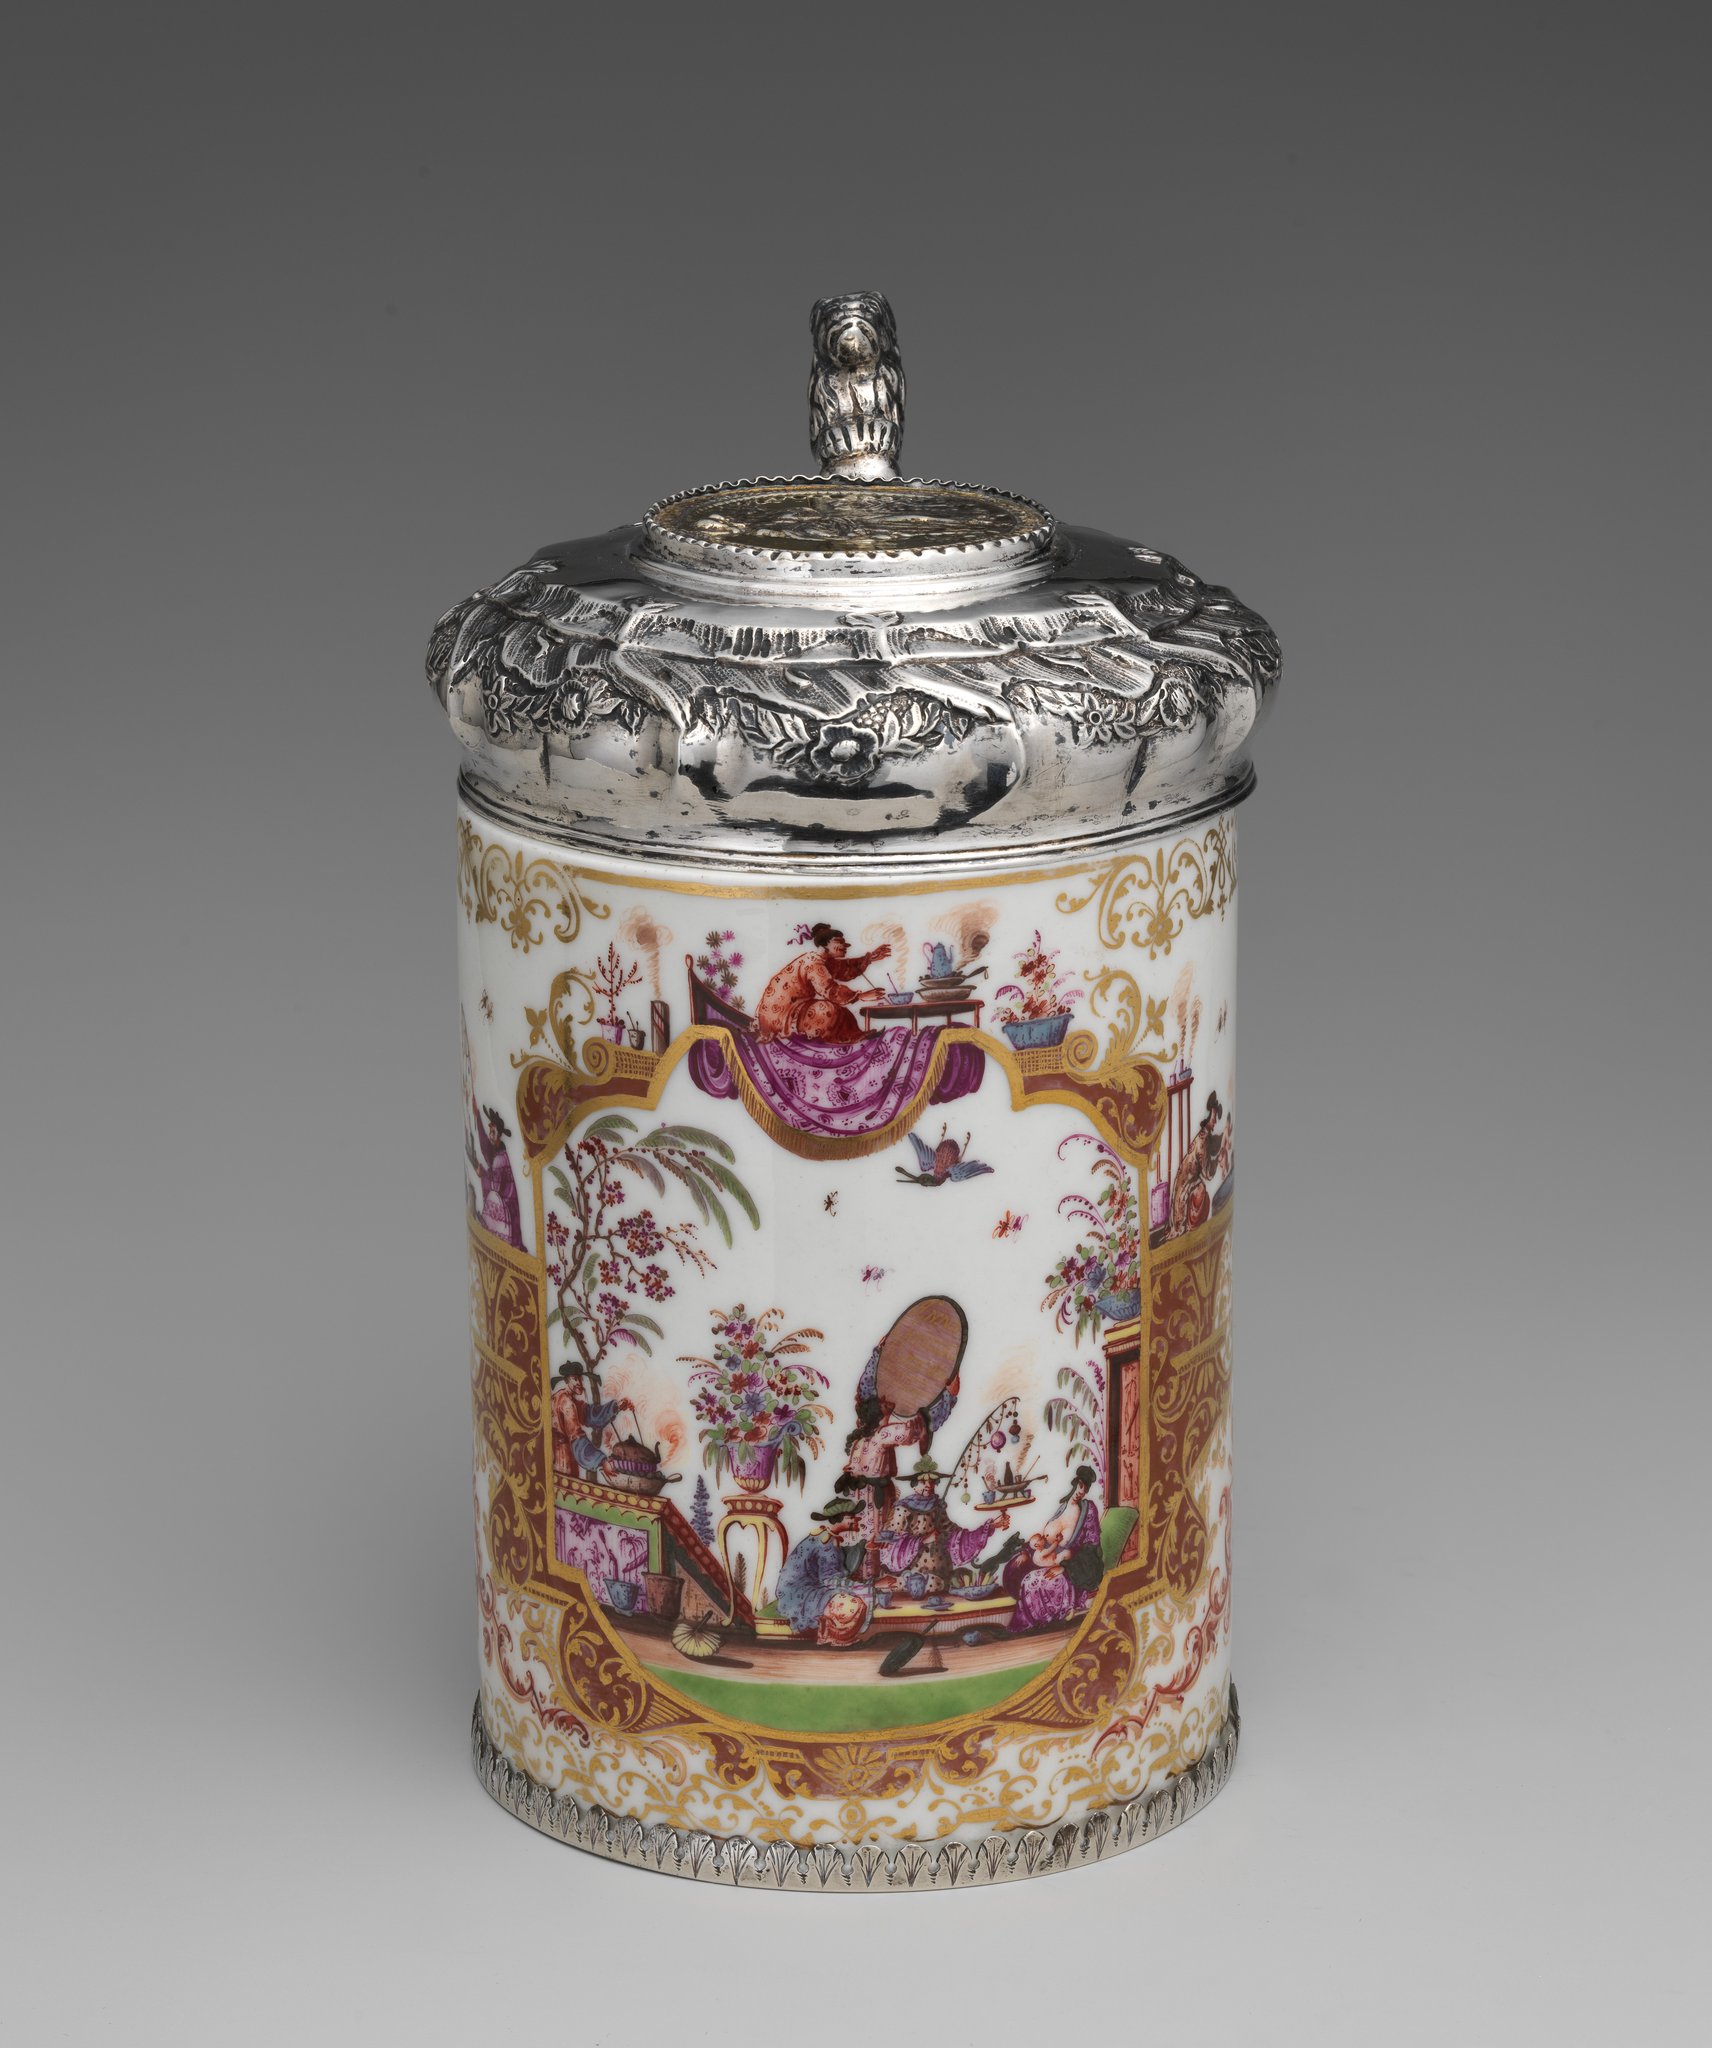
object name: tankard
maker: meissen manufactory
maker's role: manufactory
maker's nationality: german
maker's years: 1710-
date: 1724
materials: hard paste porcelain, silver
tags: infants,men,women